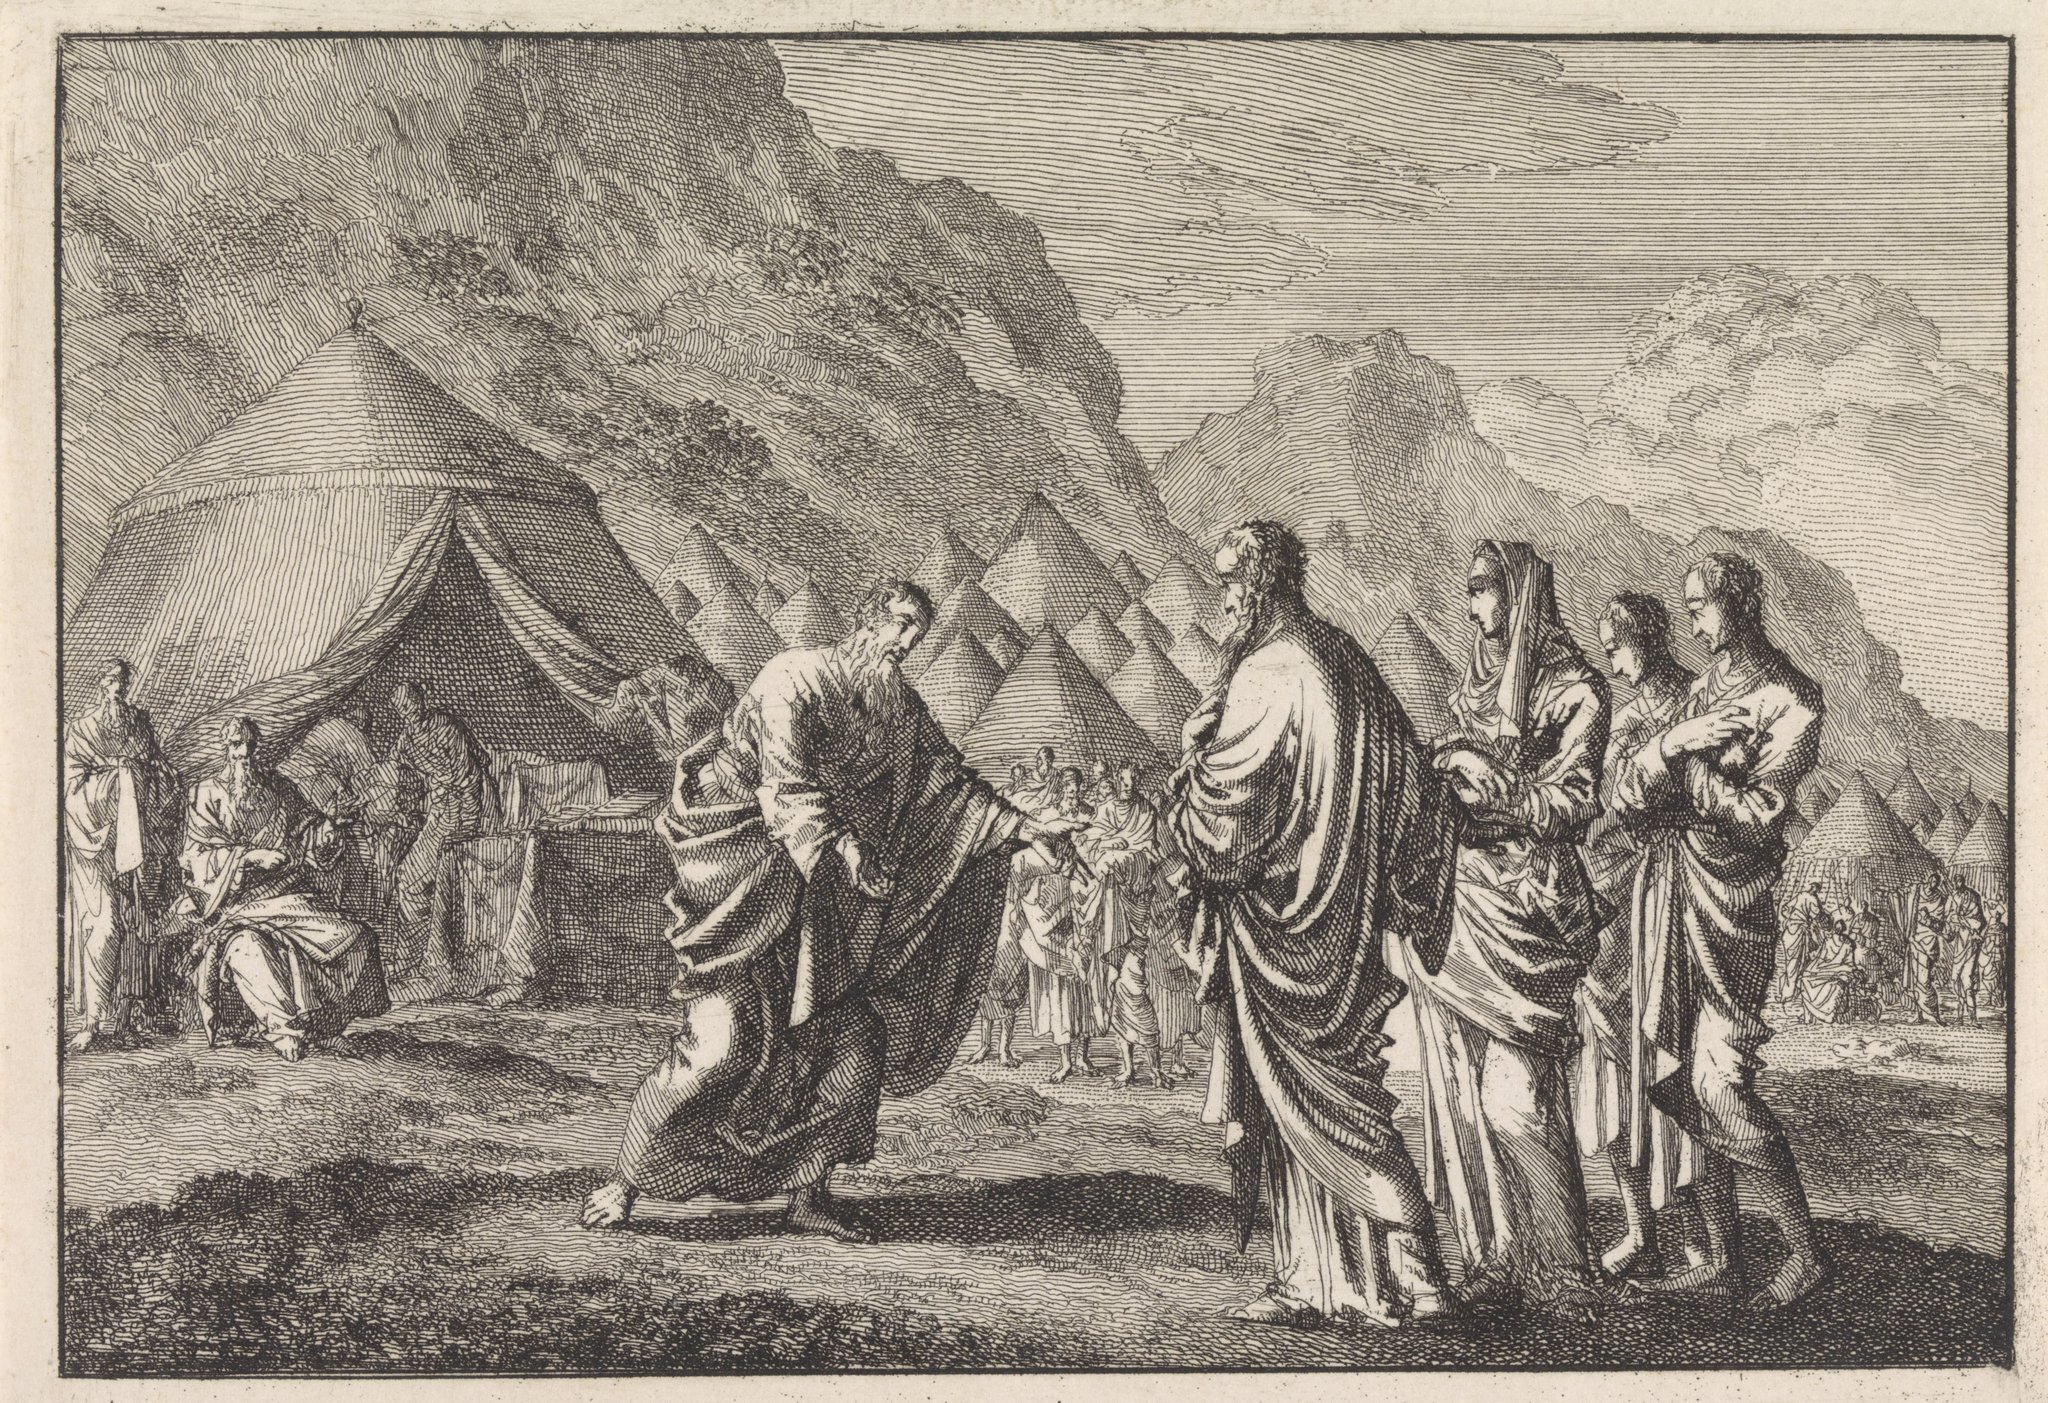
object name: print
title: Mozes ontvangt zijn schoonvader Jetro en zijn familie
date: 1703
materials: paper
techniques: etching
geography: amsterdam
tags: jethro and moses meeting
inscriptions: collector's mark: Lugt 2228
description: Proefdruk van een boekillustratie voor David Martin. Historie des Ouden en Nieuwen Testaments. Amsterdam, Pieter Mortier, 1703. Deel I. De boekillustraties voor de Mortierbijbel hebben verschillende staten en kopieën, waarbij de chronologische volgorde moeilijk te achterhalen valt. Als boekillustraties werden ze bovendien herhaaldelijk opnieuw gebruikt voor andere boekwerken.